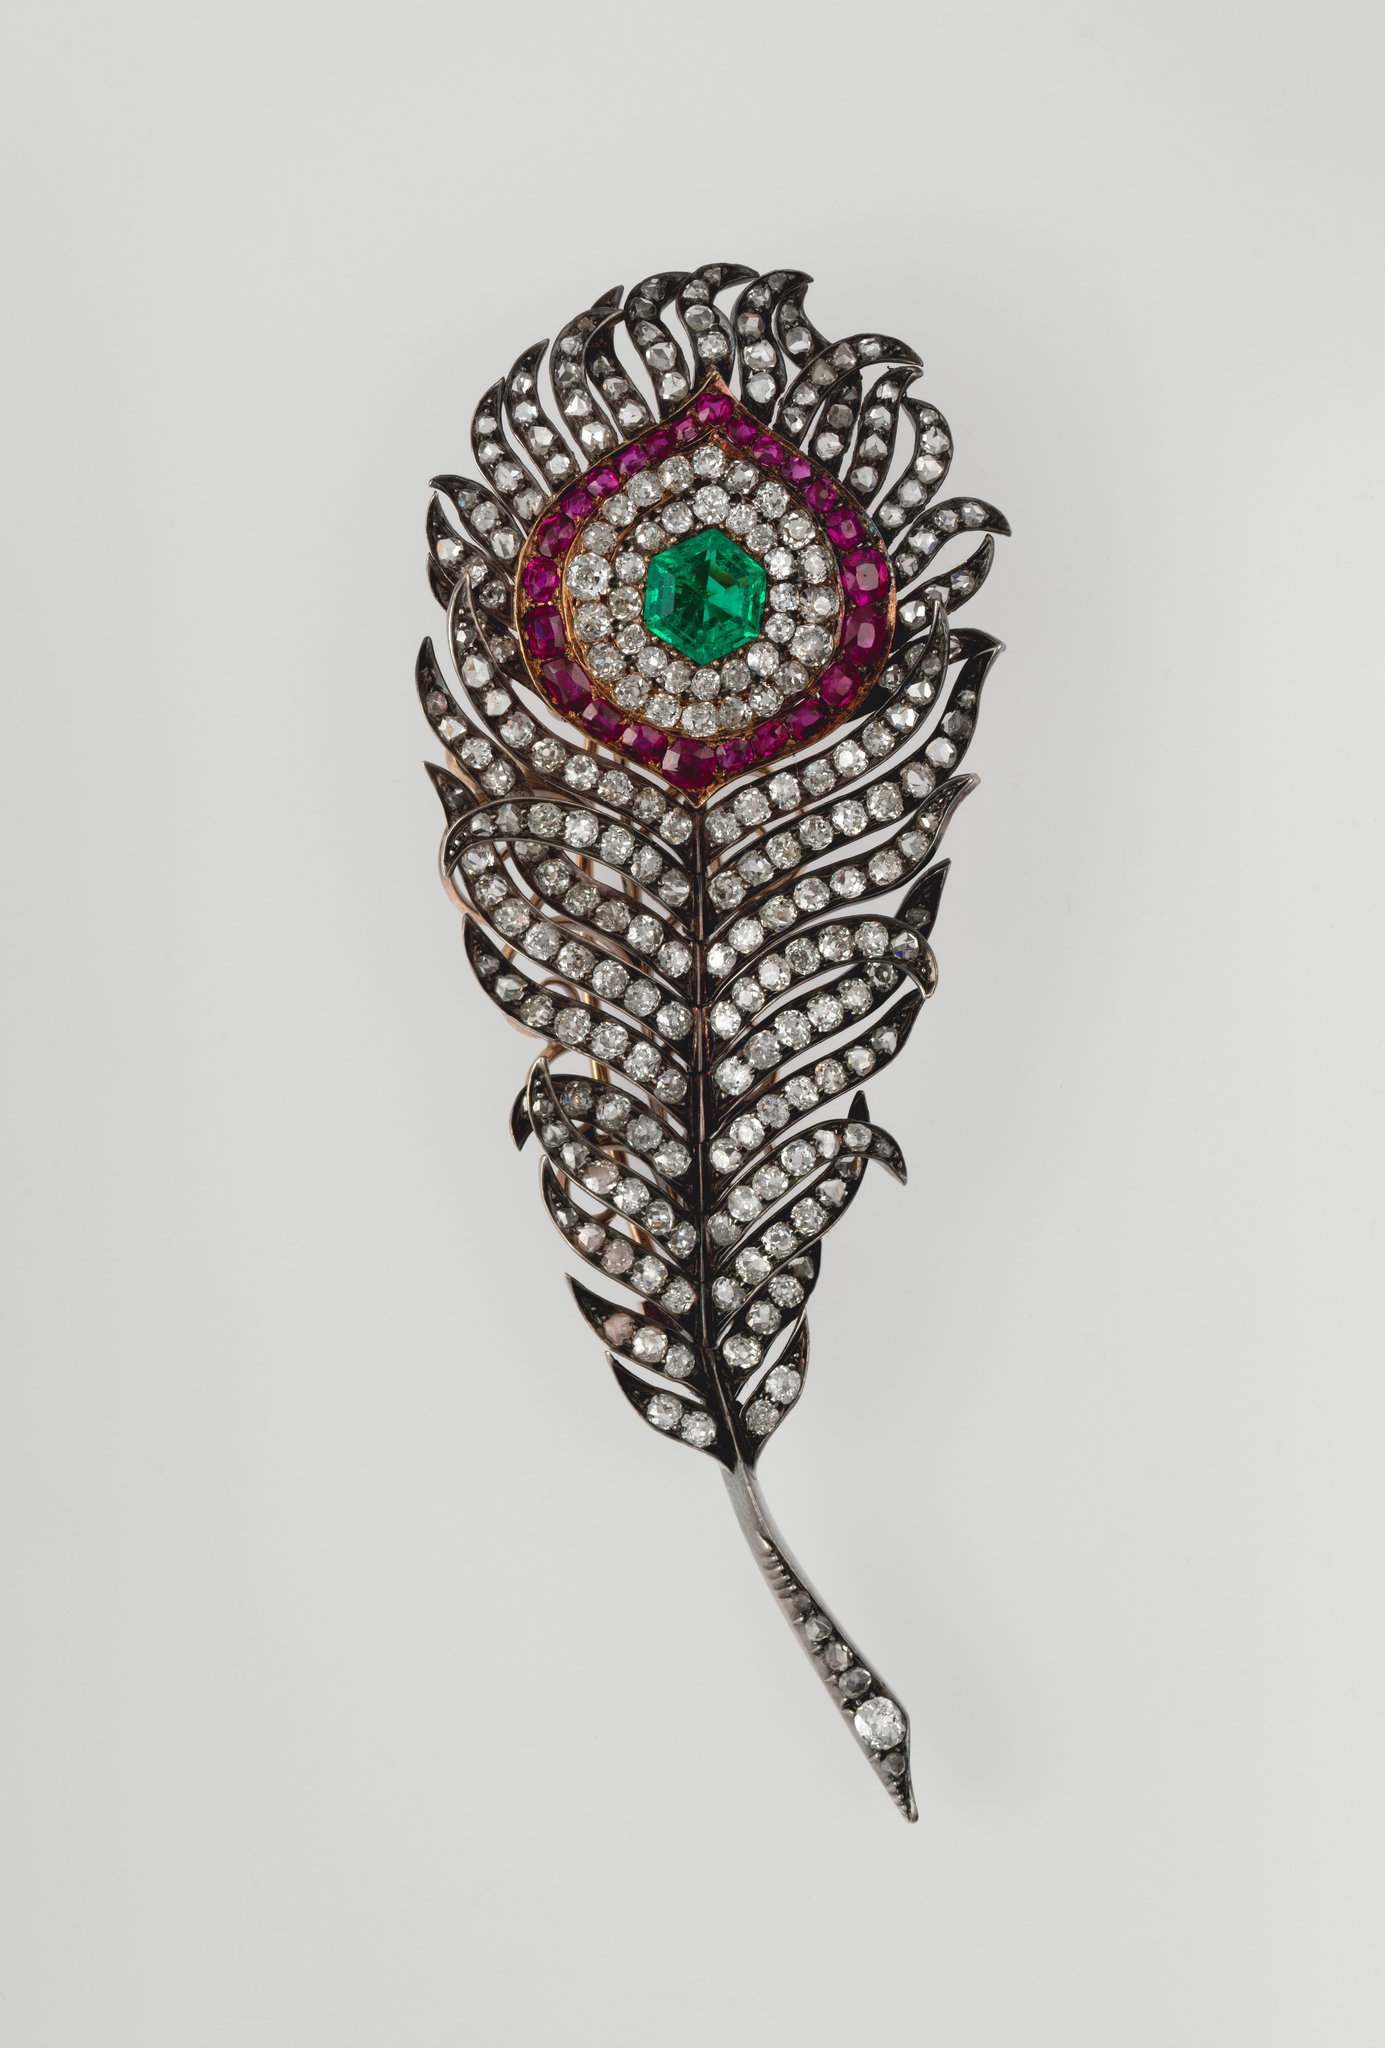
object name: brooch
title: Peacock feather brooch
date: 1876-1900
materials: diamond, gemstone, gold, silver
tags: feathers